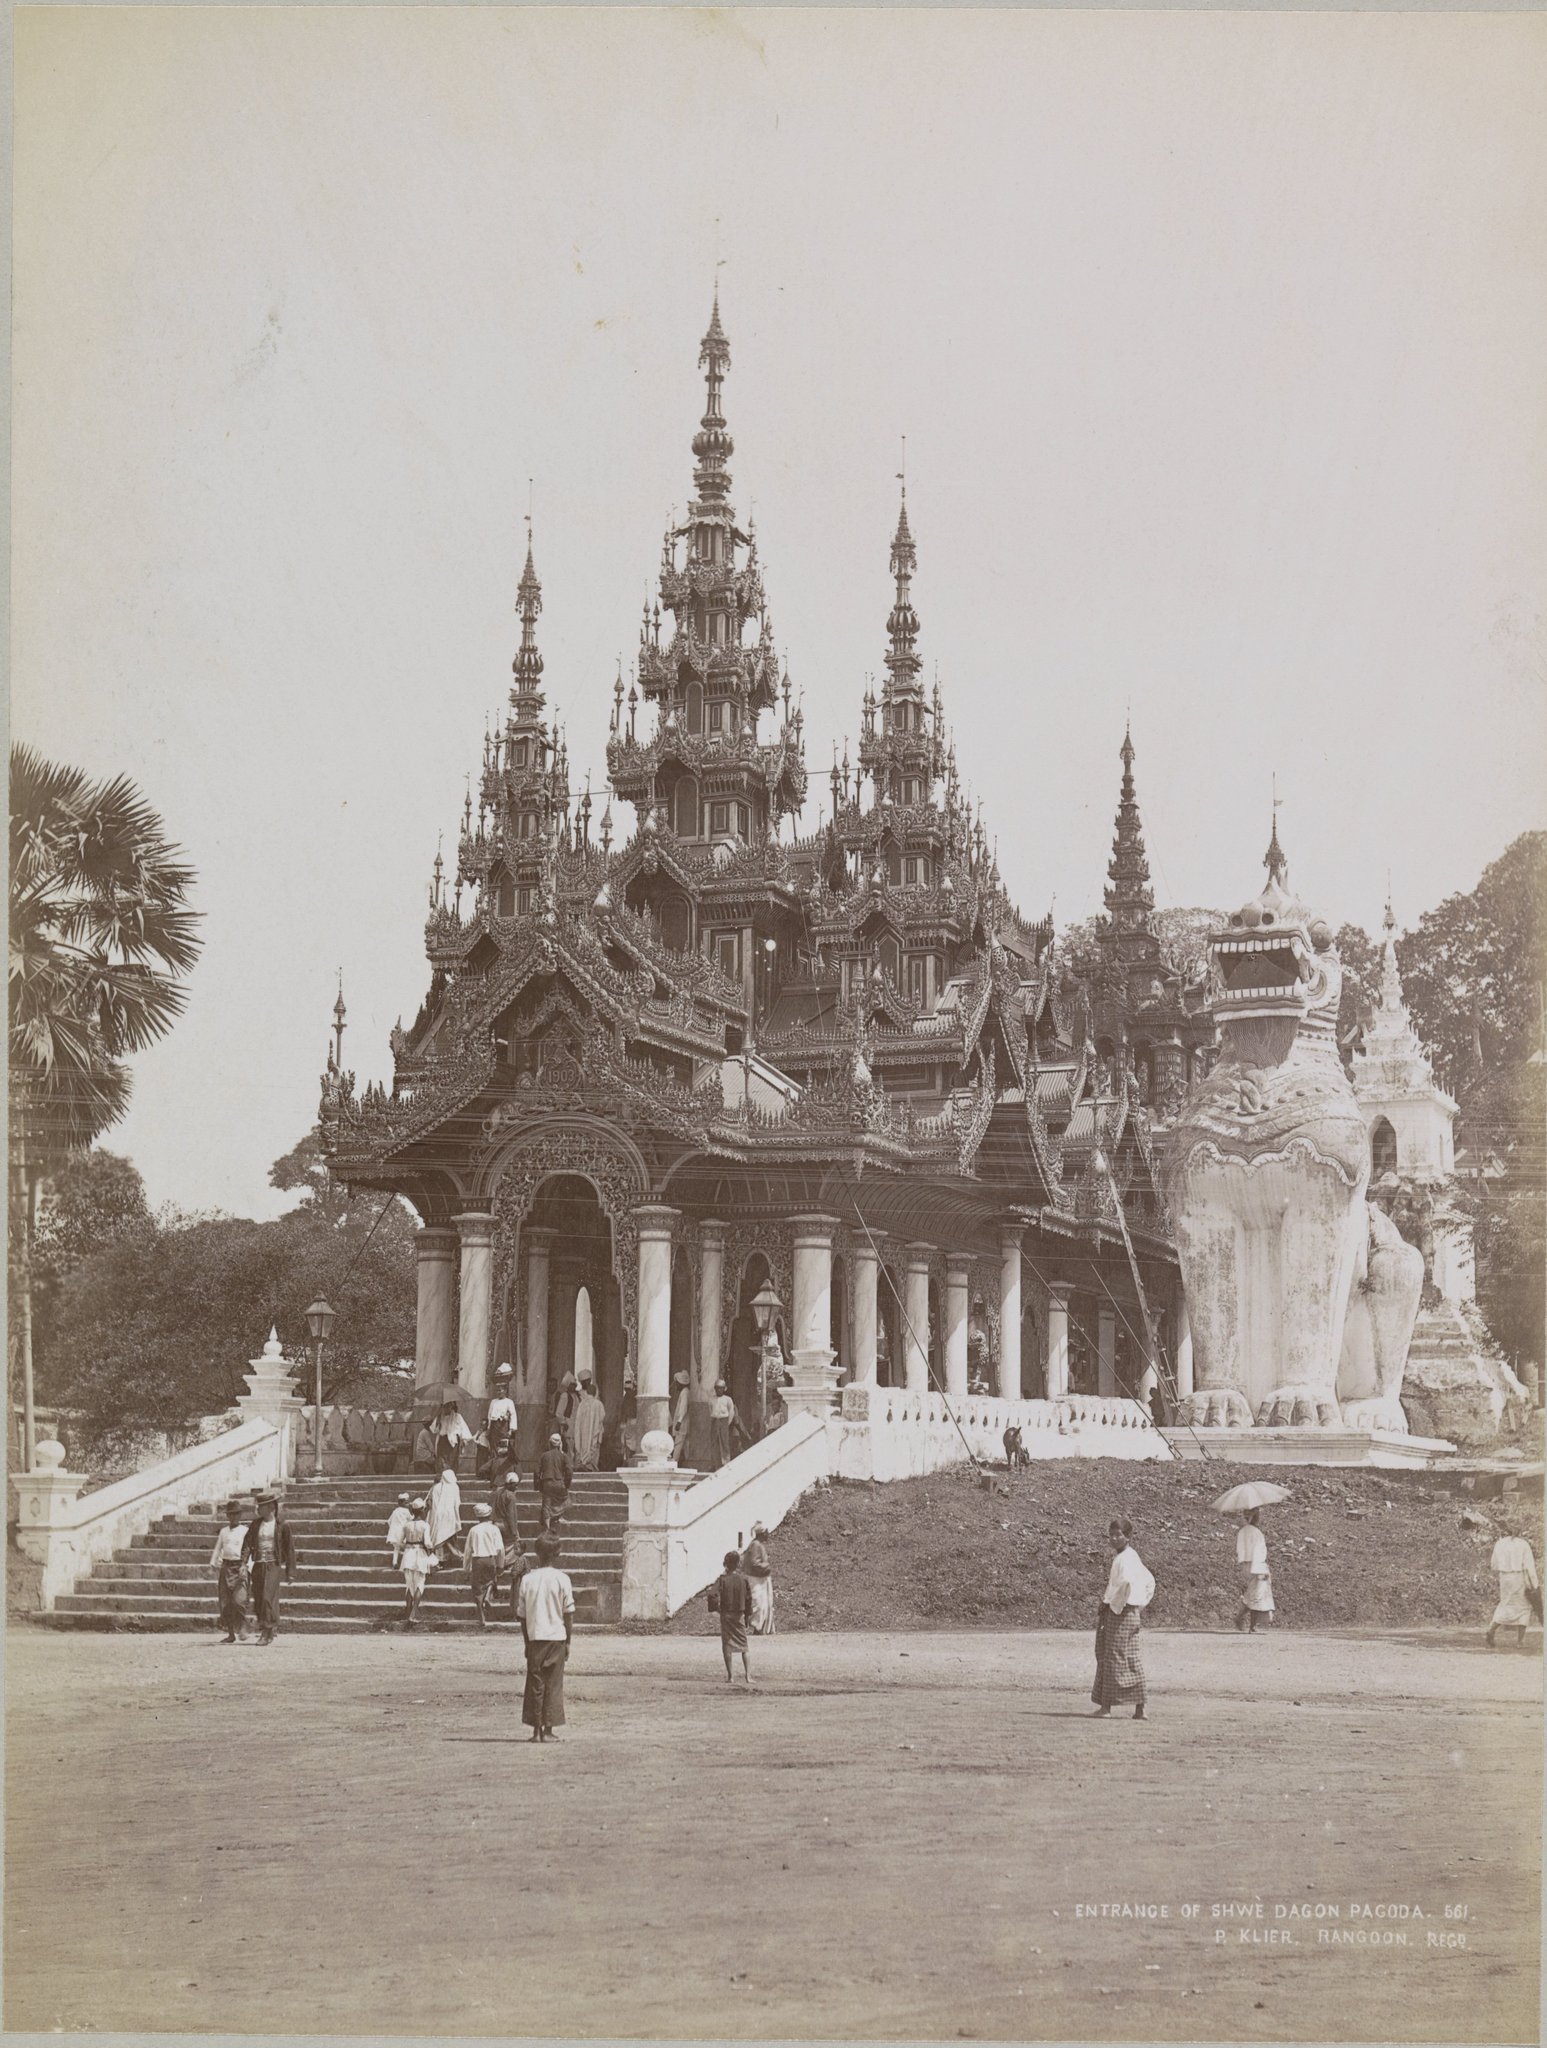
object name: photograph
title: Entrance to the Shwedagon pagoda, Yangon, Myanmar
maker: philip adolphe klier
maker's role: fotograaf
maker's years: 1845-1911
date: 1895-1915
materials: cardboard, paper, photographic support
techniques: albumen print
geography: yangon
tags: yangon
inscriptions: inscription: ‘Entrance of Shwé Dagon Pagoda. 561./ P. Klier. Rangoon. Rego.’, number: ‘1.’